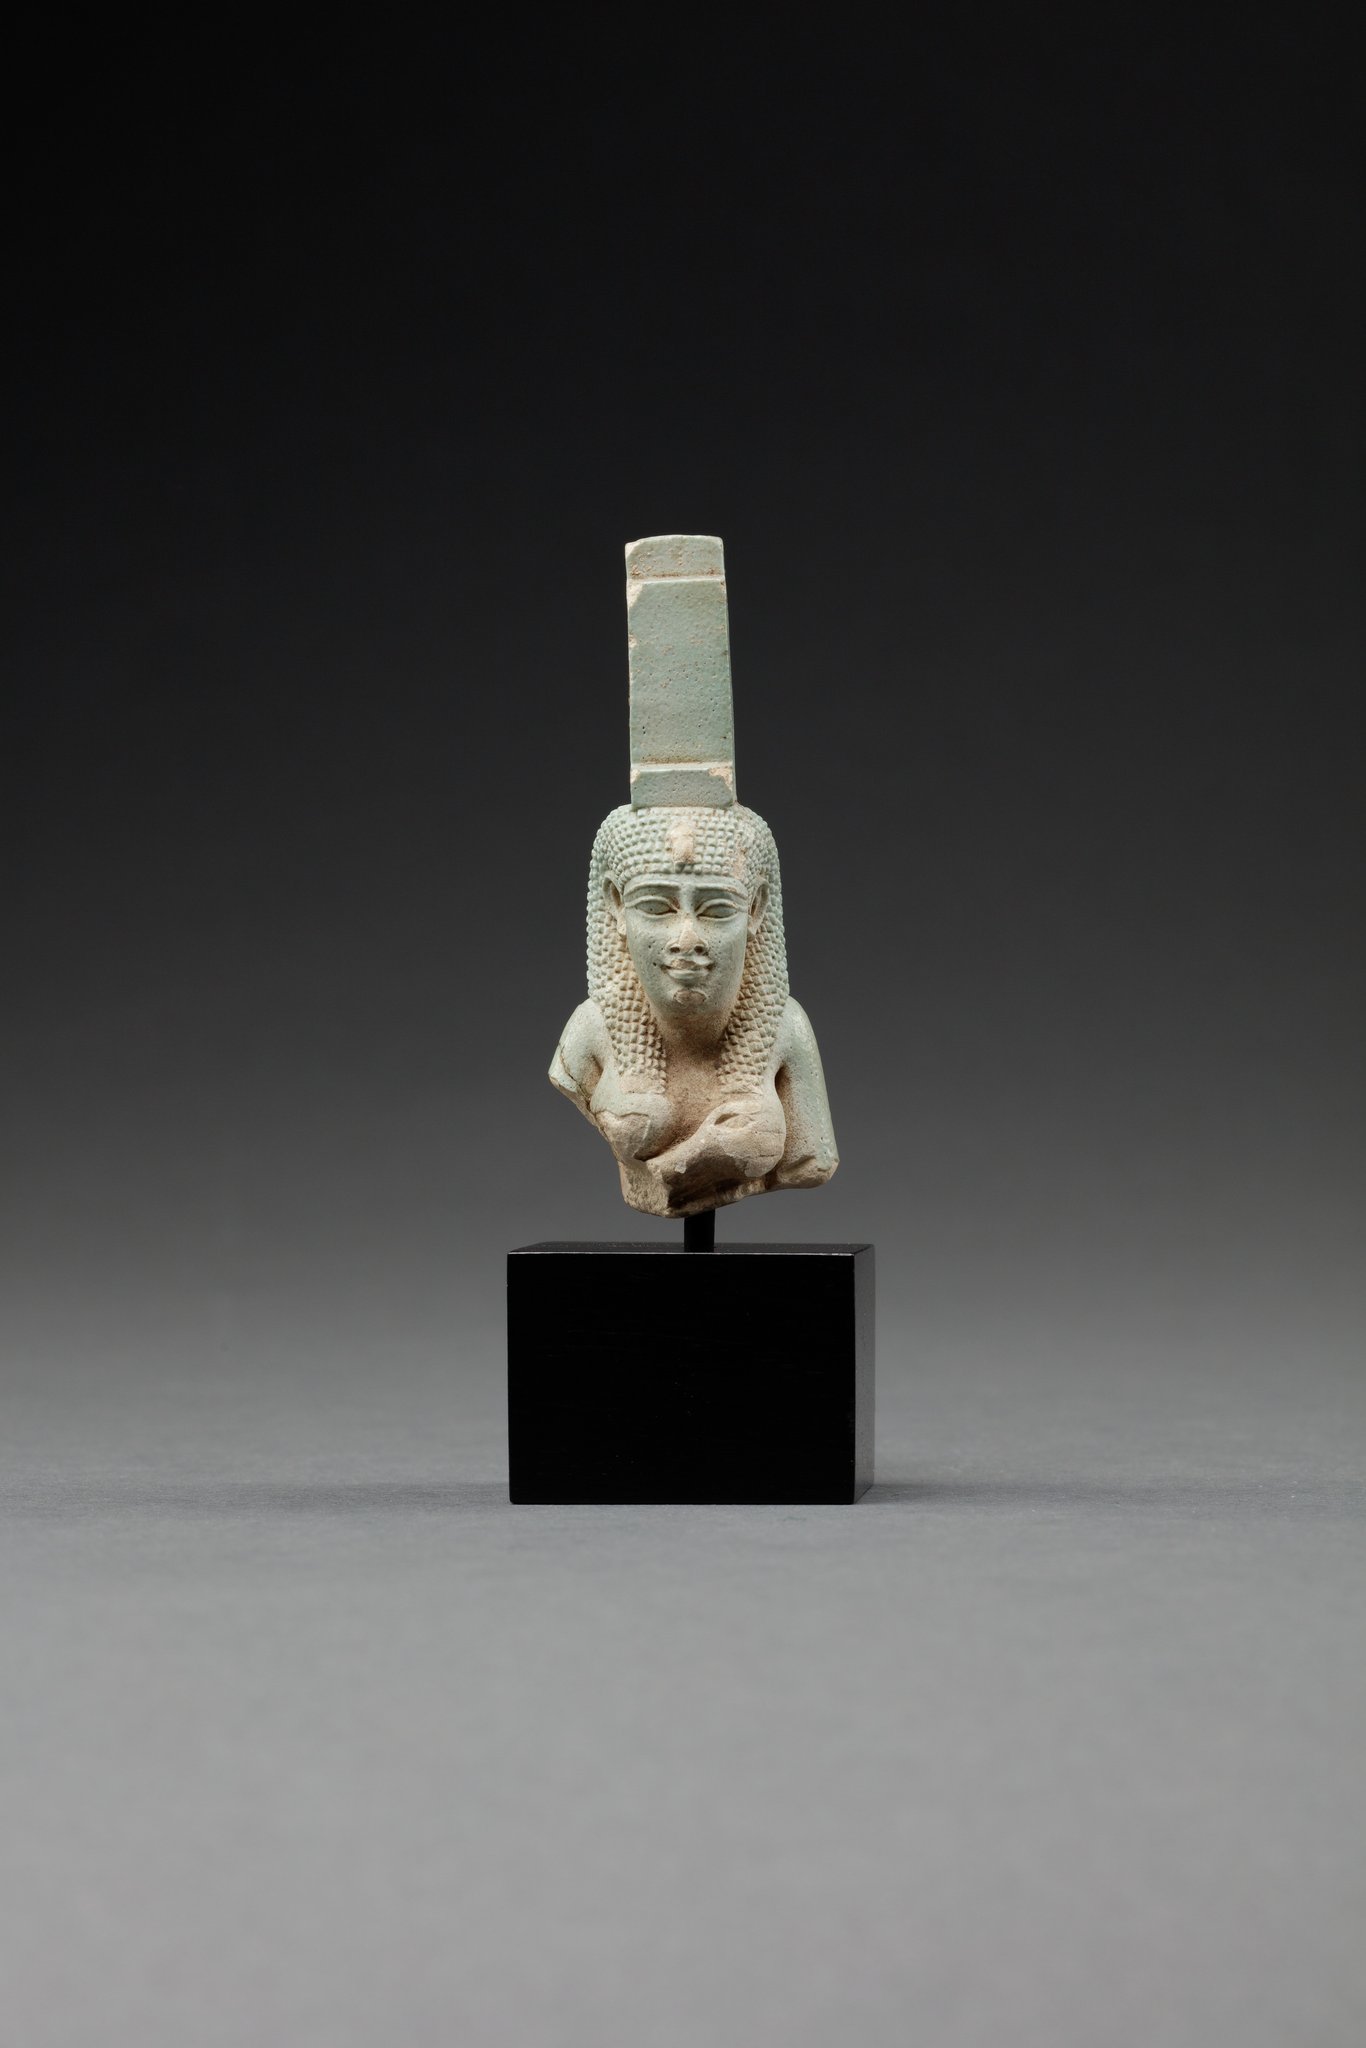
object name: upper part of a figure depicting isi nursing horus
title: Upper part of a figure of Isis nursing Horus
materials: faience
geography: egypt